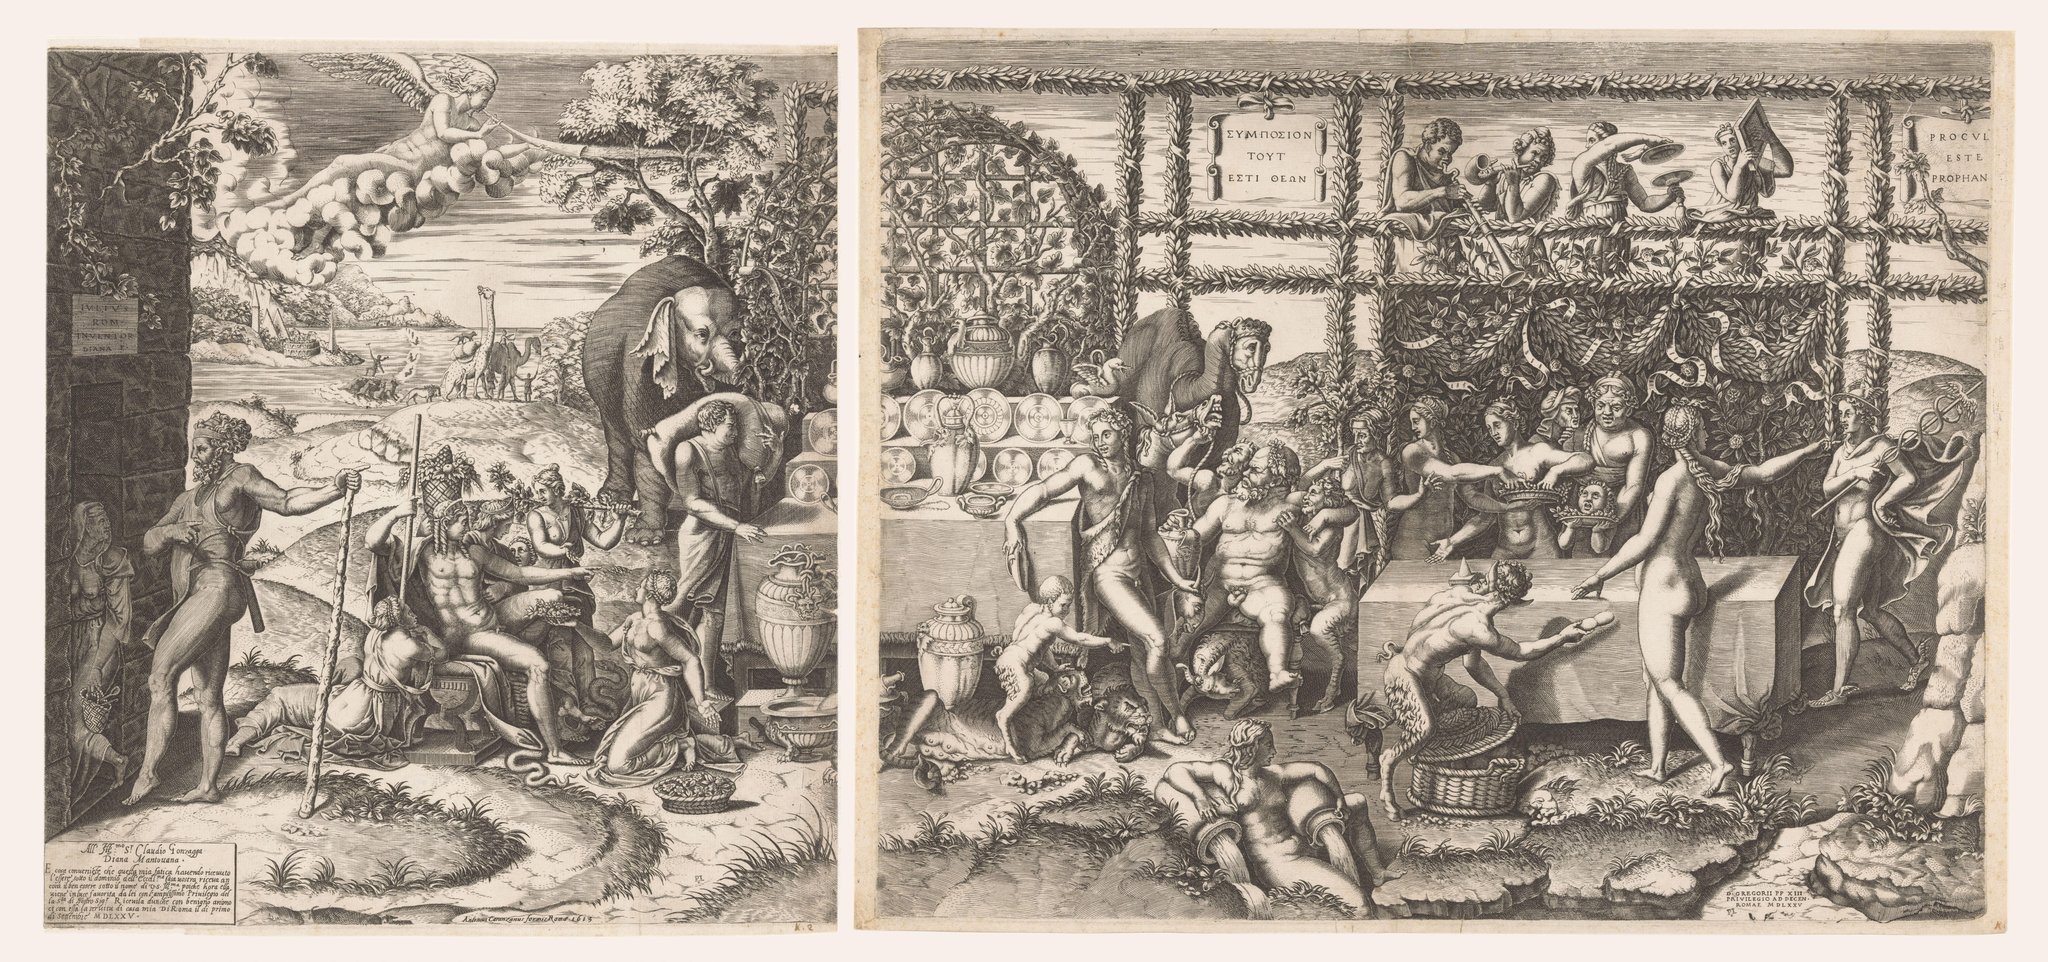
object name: print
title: Voorbereidingen voor het huwelijksfeest van Amor en Psyche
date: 1575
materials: paper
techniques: engraving, etching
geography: vatican city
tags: (story of) bacchus (dionysus), liber, (story of) mercury (hermes), marriage of cupid and psyche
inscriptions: collector's mark: Lugt 2228, collector's mark: Lugt 2092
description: Door verscheidene mythologische figuren wordt het huwelijksfeest van Amor en Psyche voorbereid. Links zit Apollo omringd door godinnen. In het midden een met luxe serviesgoed gedekte tafel en een tweede tafel met daaromheen Bacchus, saters, Mercurius en de gratiën.